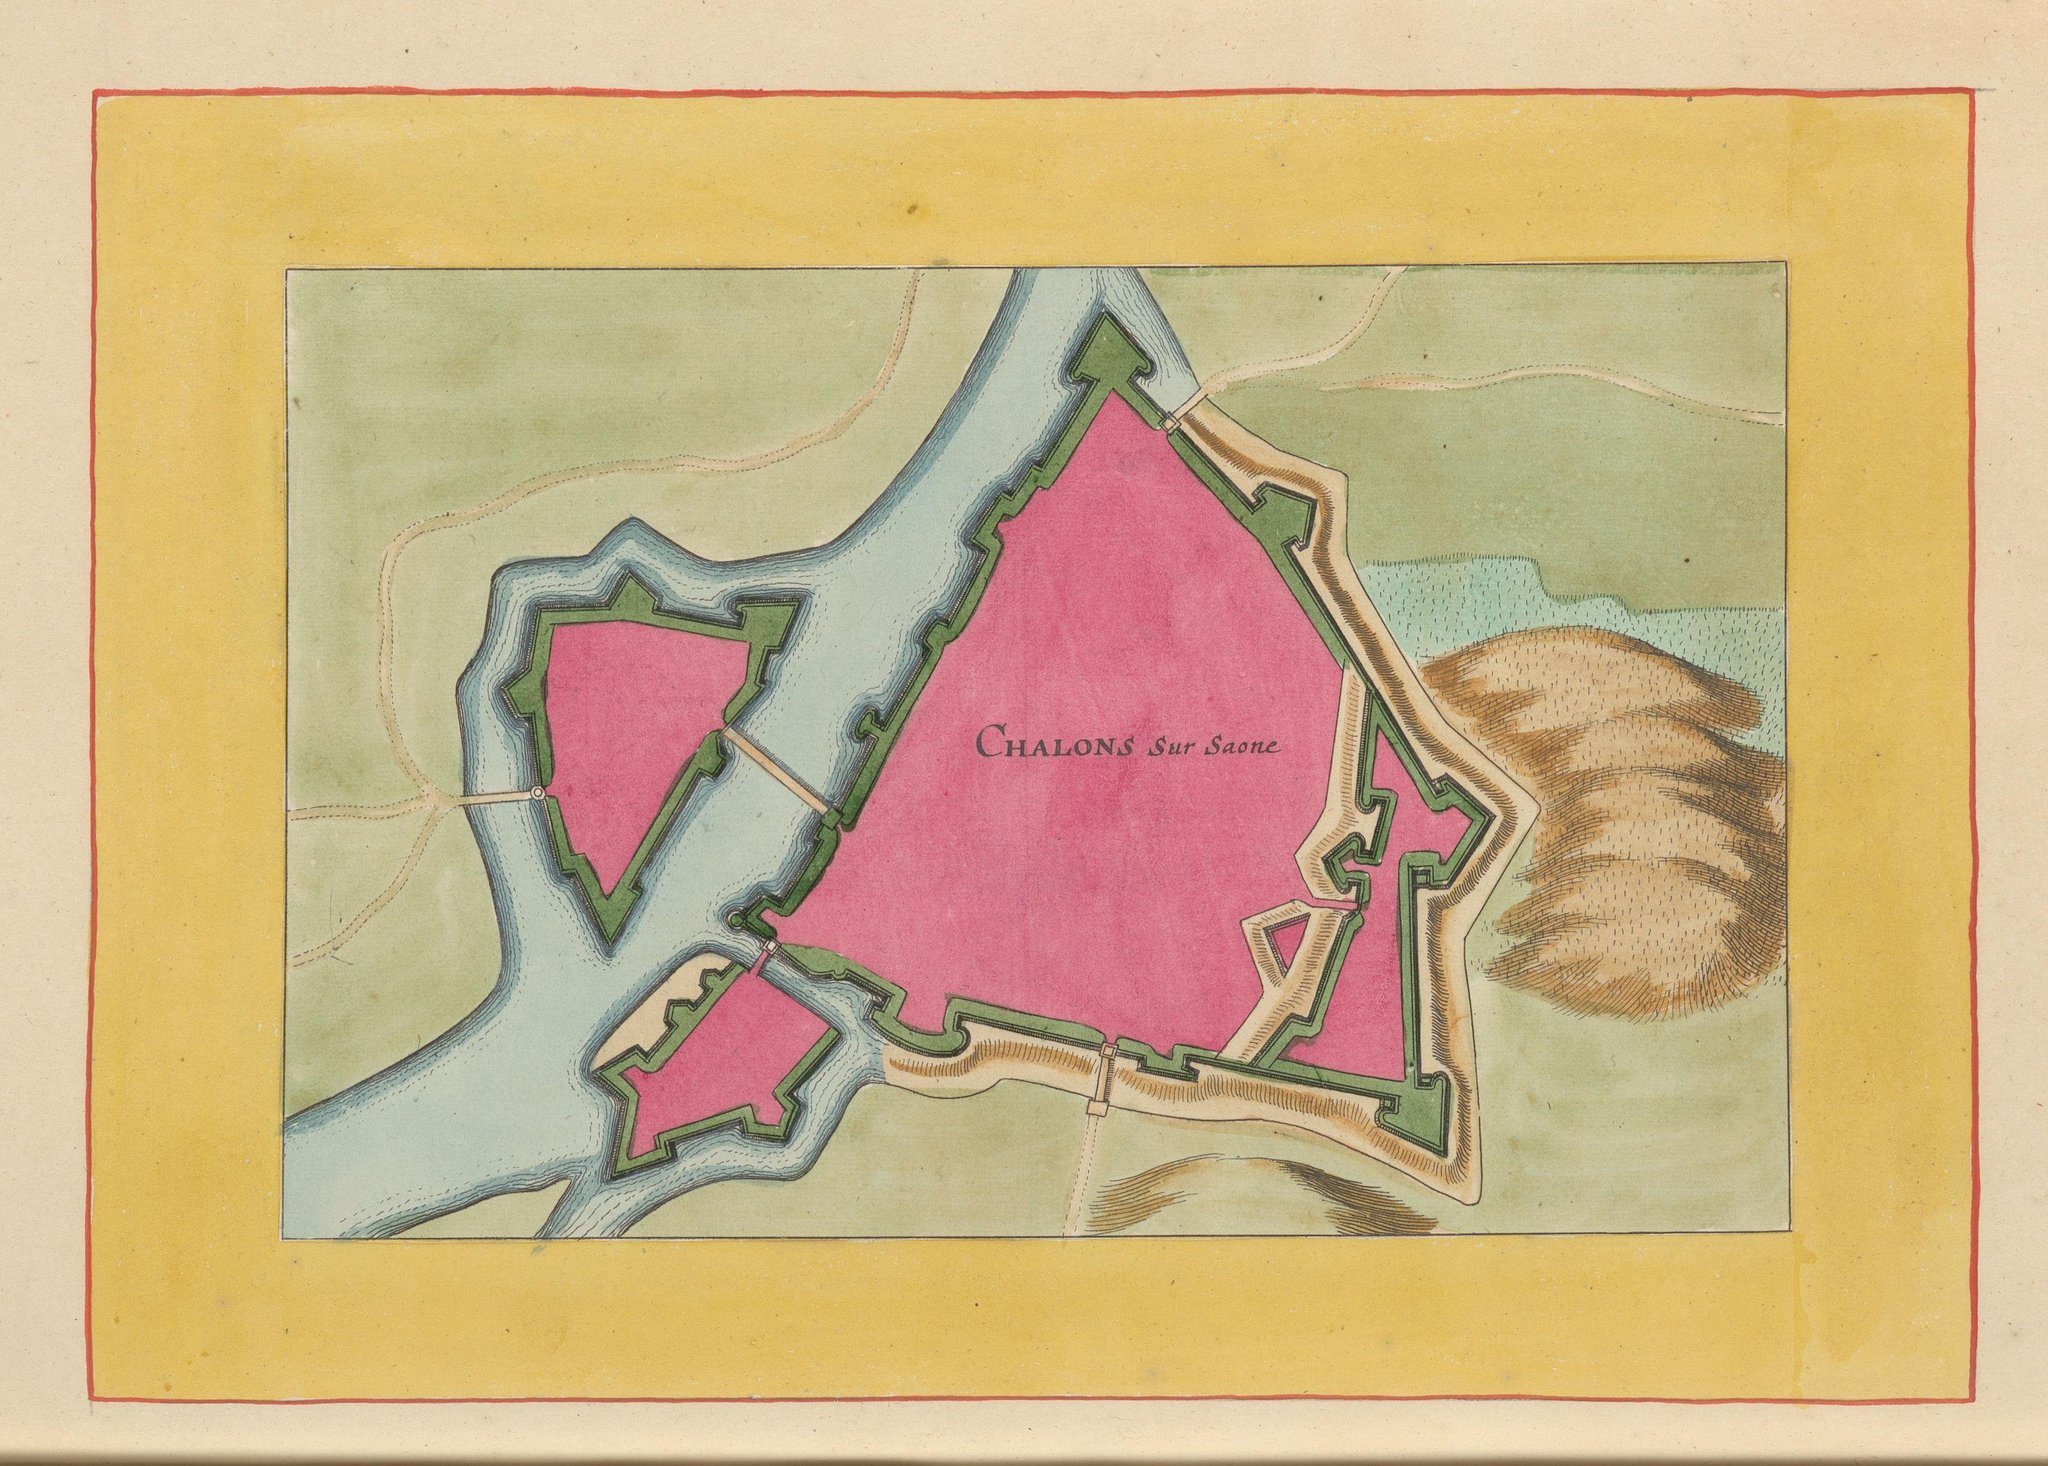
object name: album leaf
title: Chalons sur Saone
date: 1656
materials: paper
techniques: engraving, etching, hand coloring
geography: frankfurt am main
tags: maps of cities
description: Prent uit: Zeiller, Martin. Topographia Galliae. 13 dln. Frankfurt: Caspar Merian, 1656, dl. 4, na p. 10.